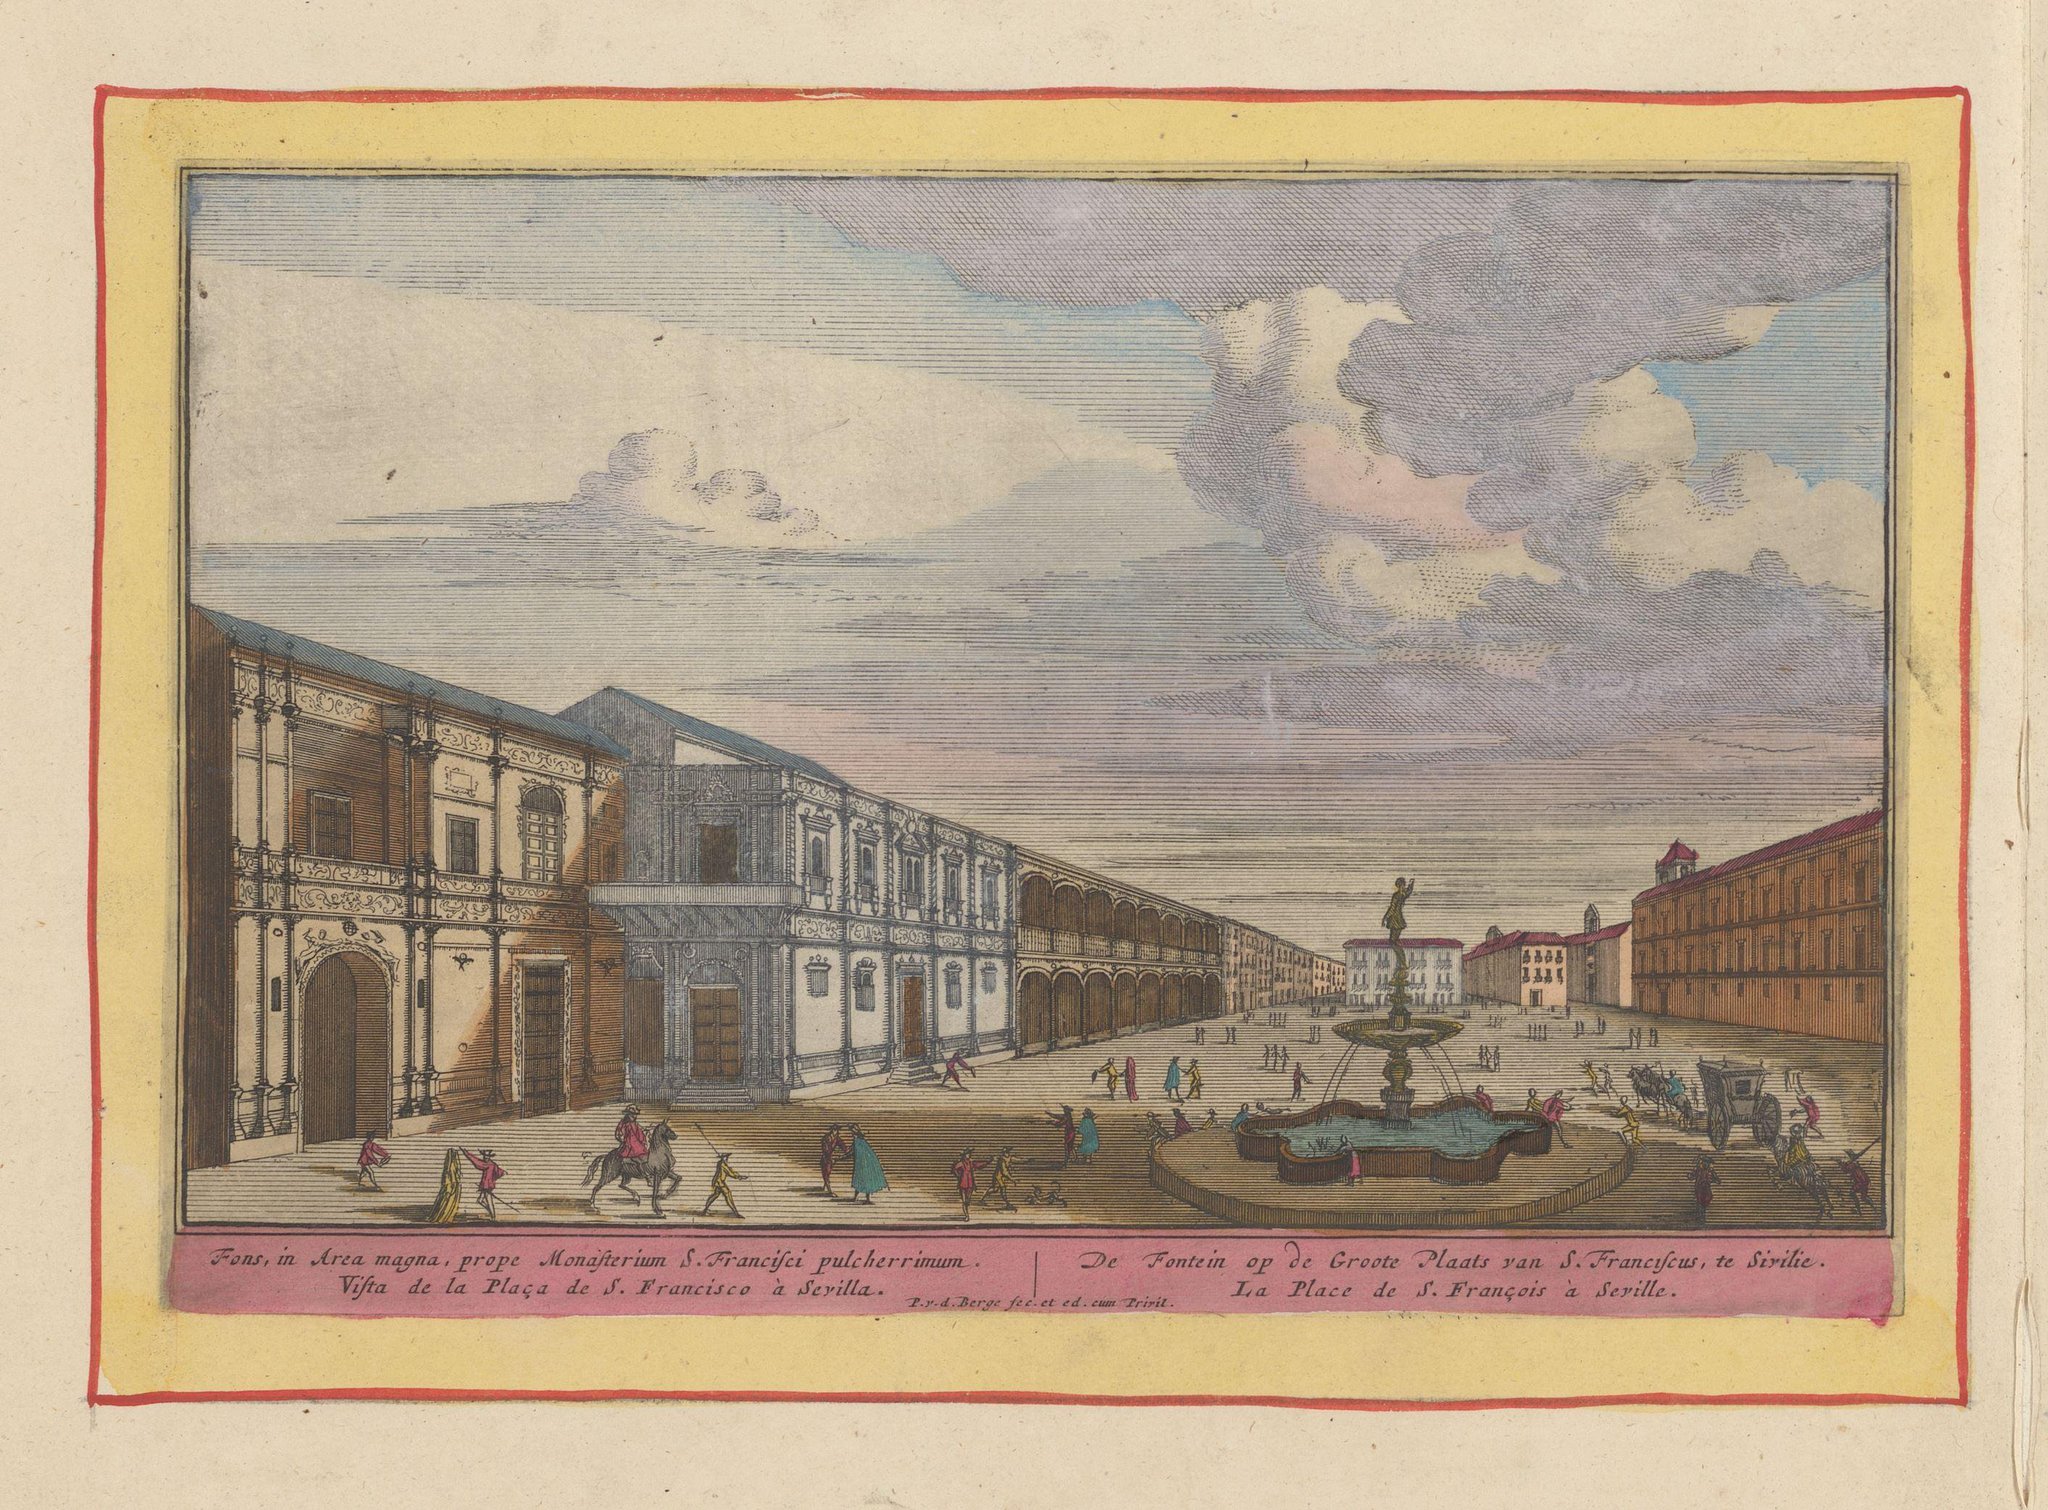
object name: book illustration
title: Theatrum Hispaniae (...)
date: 1694-1737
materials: paper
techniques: etching, hand coloring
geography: amsterdam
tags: ornamental fountain, sevilla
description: Prent uit: Theatrum Hispaniæ, exhibens regni urbes, villas ac viridaria magis illustria. Het aanmerkelykste en voortreffelykste in Spanjen (...). Amsterdam: Pieter van den Berge, ca. 1694-1737.